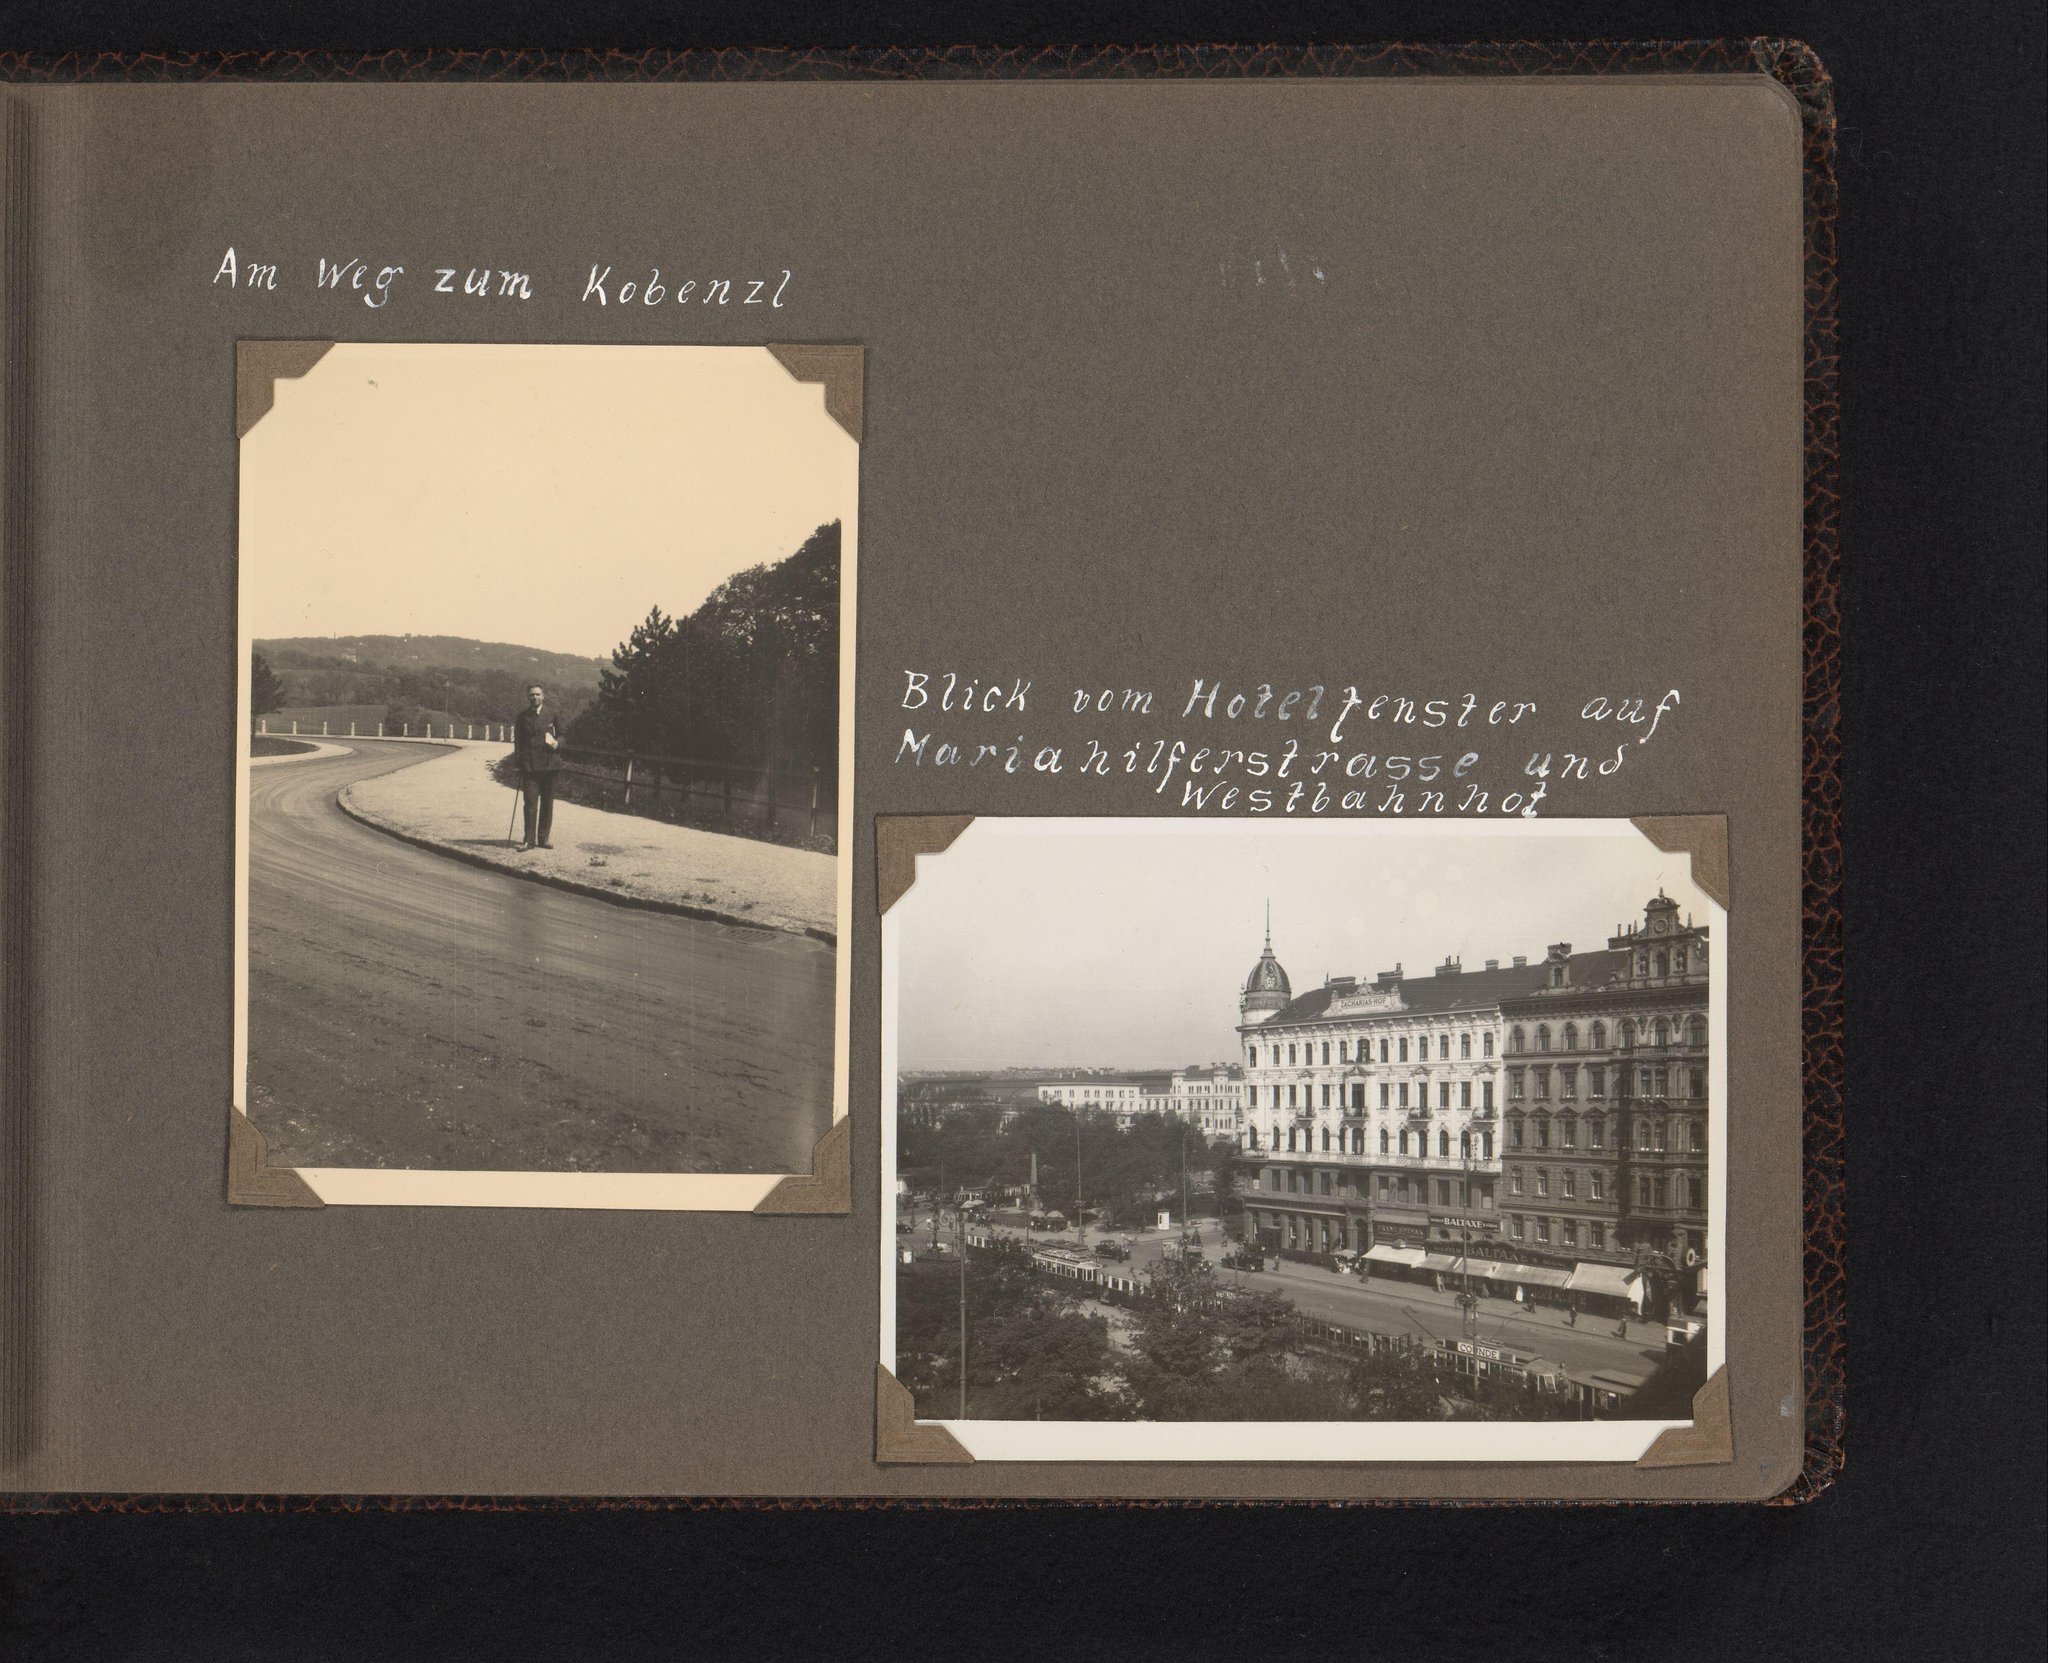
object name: album leaf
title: Herman Bessleaar langs een weg en een stadsgezicht van Wenen nabij de Westbahnhof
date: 1930-1931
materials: cardboard, paper, photographic support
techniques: gelatin silver print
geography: vienna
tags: herman besselaar, city-view in general; 'veduta', historical persons, vienna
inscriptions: annotation: ‘Am weg zum Kobenzl/ Blick vom hotelfenster auf Mariahilferstrasse und Westbahnhof’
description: Twee foto's gemaakt tijdens de verlovingsreis naar Wenen en Boedapest. Deze pagina maakt deel uit van een album.